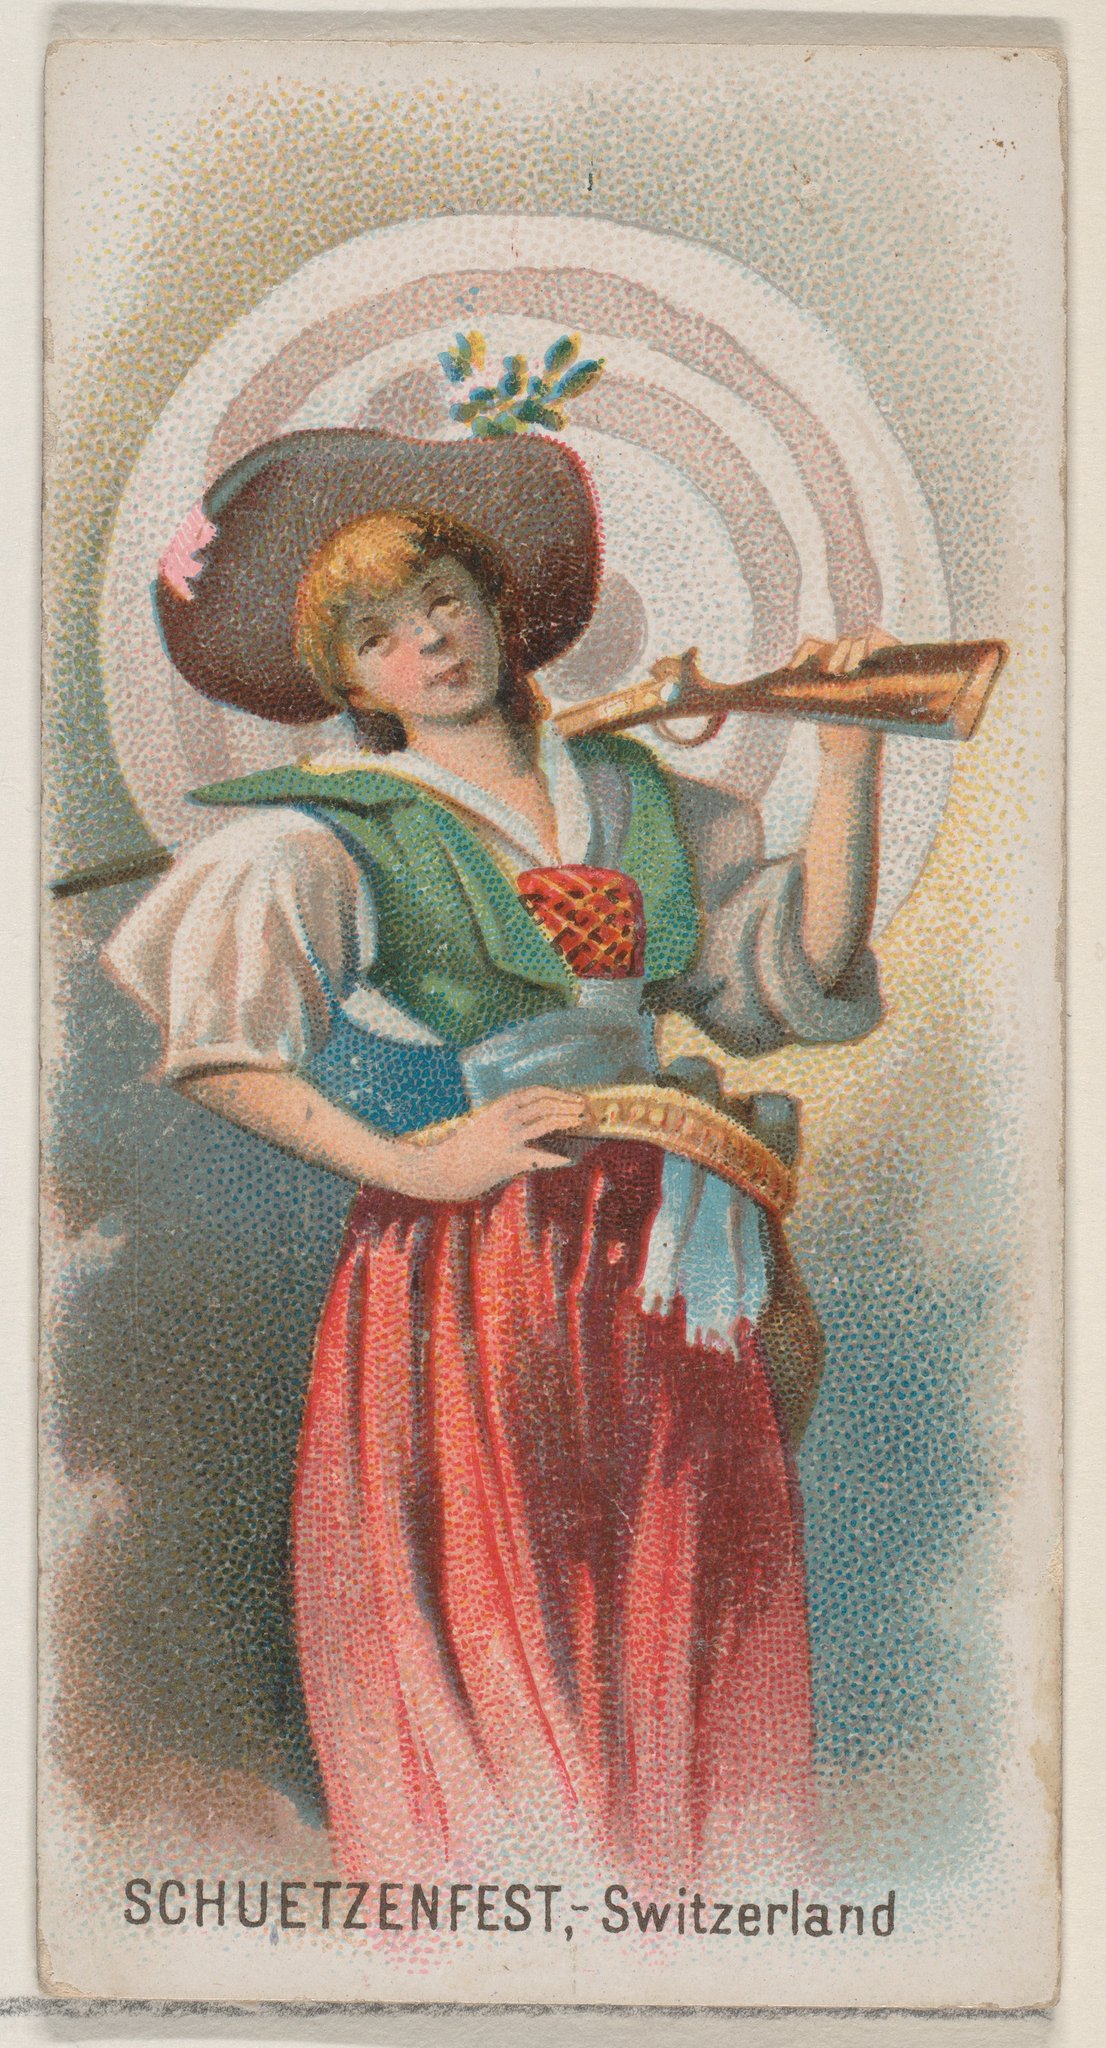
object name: print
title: Schuetzenfest, Switzerland, from the Holidays series (N80) for Duke brand cigarettes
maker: w. duke, sons & co.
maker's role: publisher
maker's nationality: american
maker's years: 1870-1920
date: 1890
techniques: color lithograph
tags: women